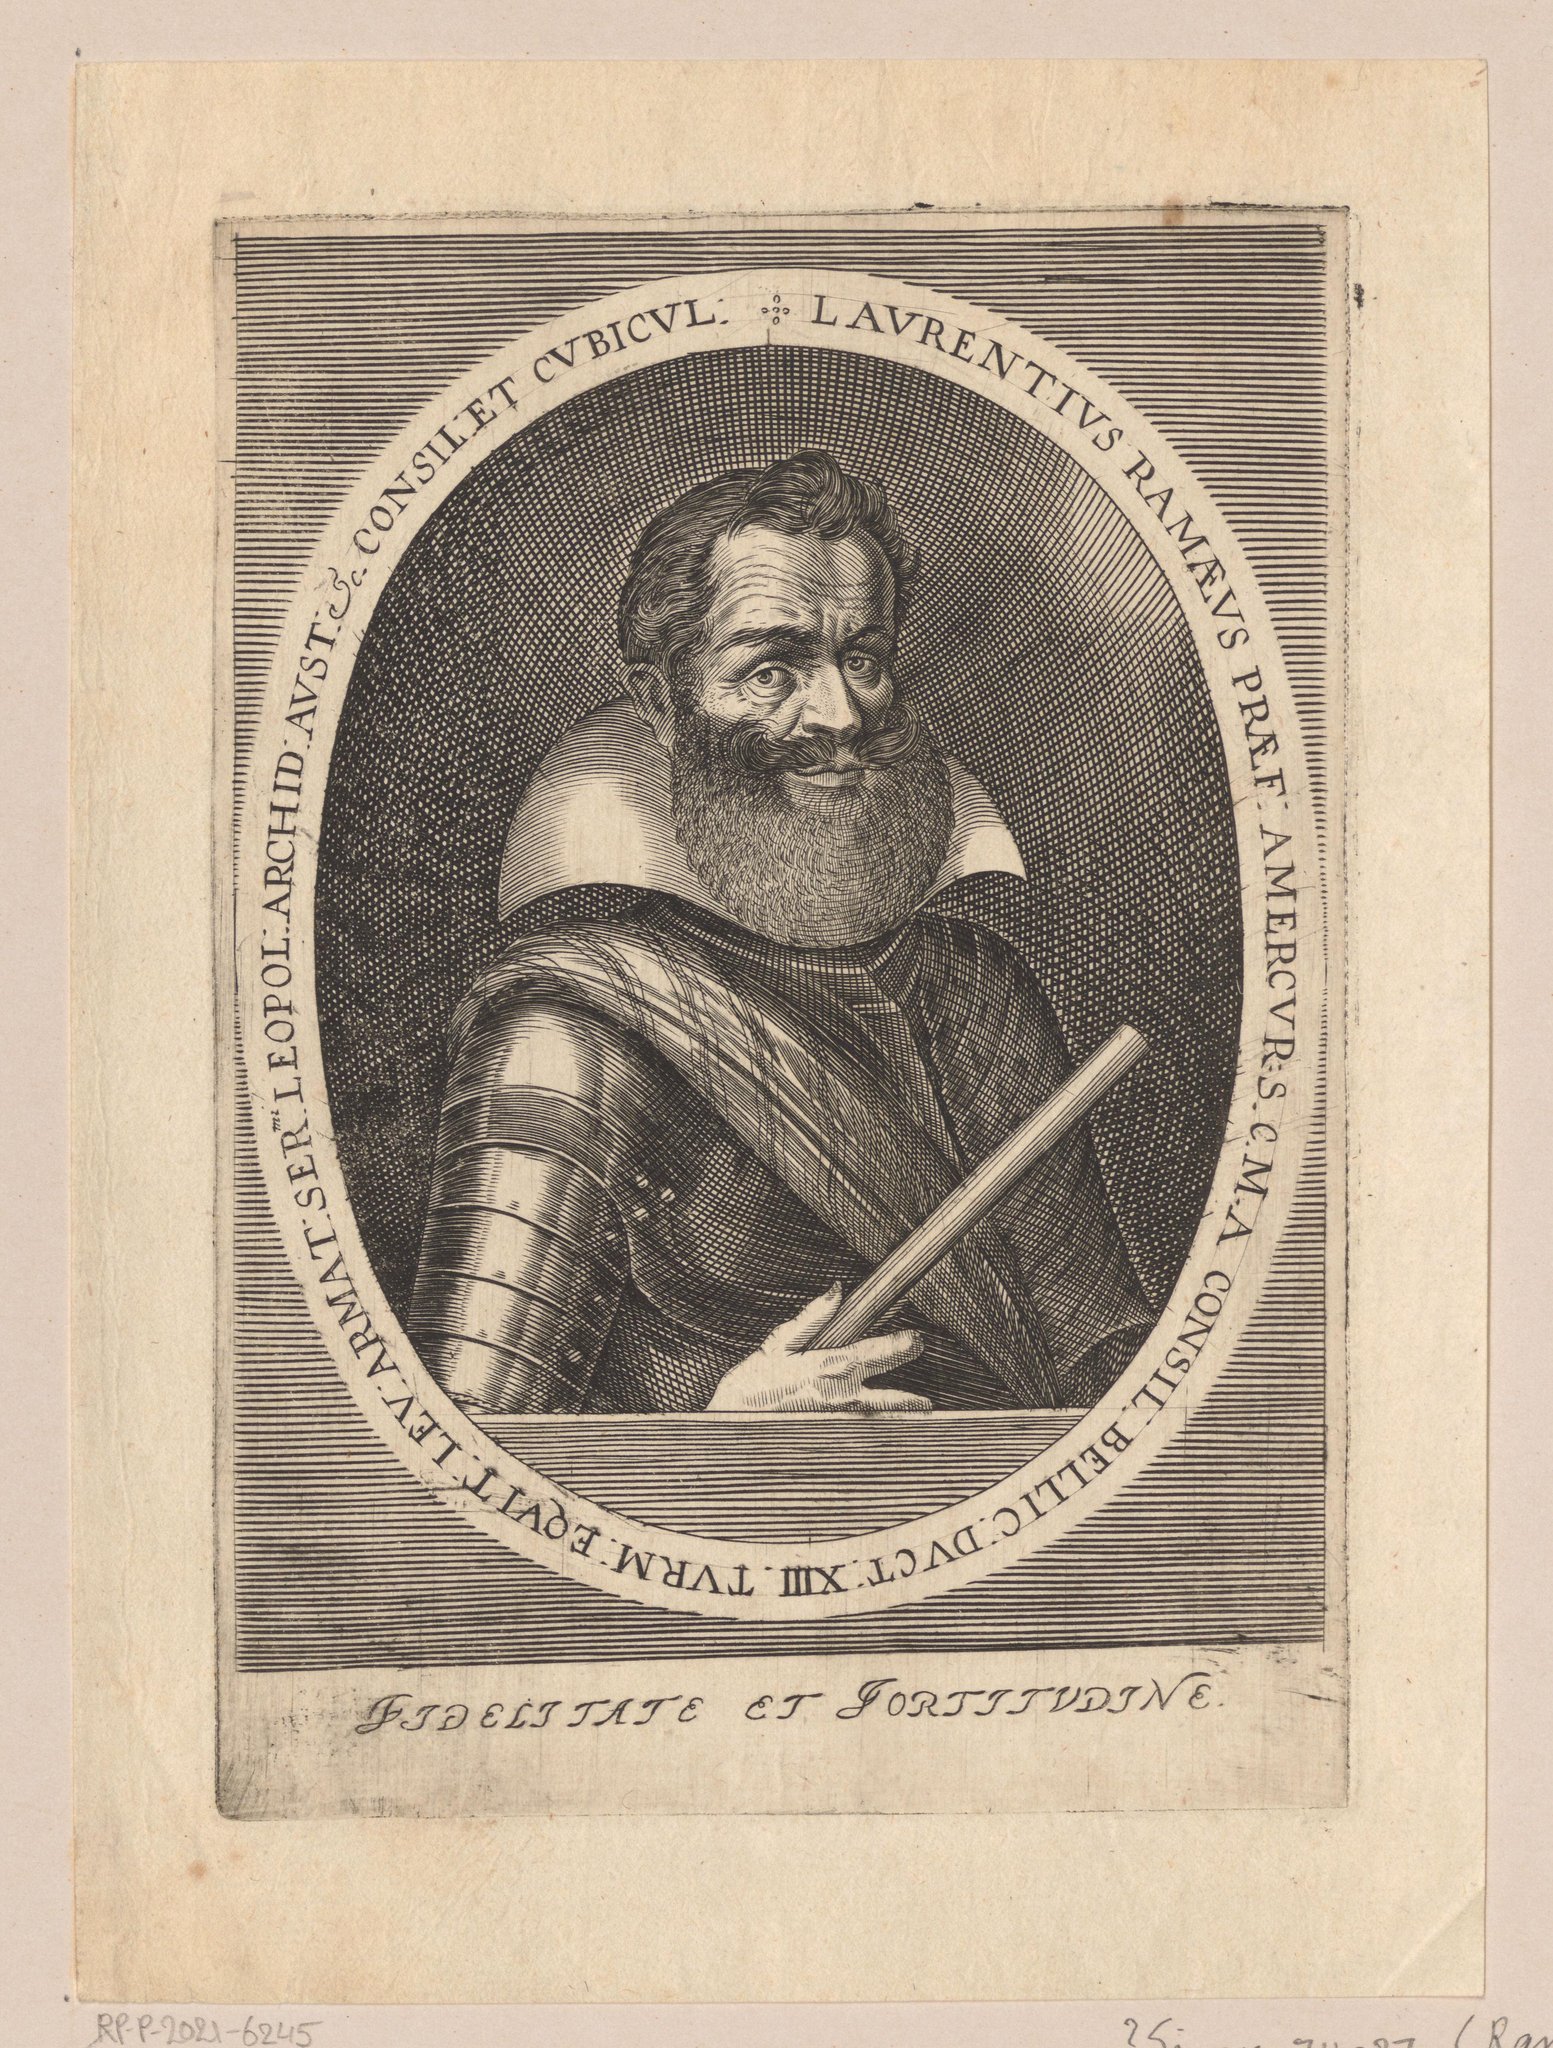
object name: print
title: Portret van Lorenz Ramee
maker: Anonymous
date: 1610-1649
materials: paper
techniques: engraving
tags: historical persons